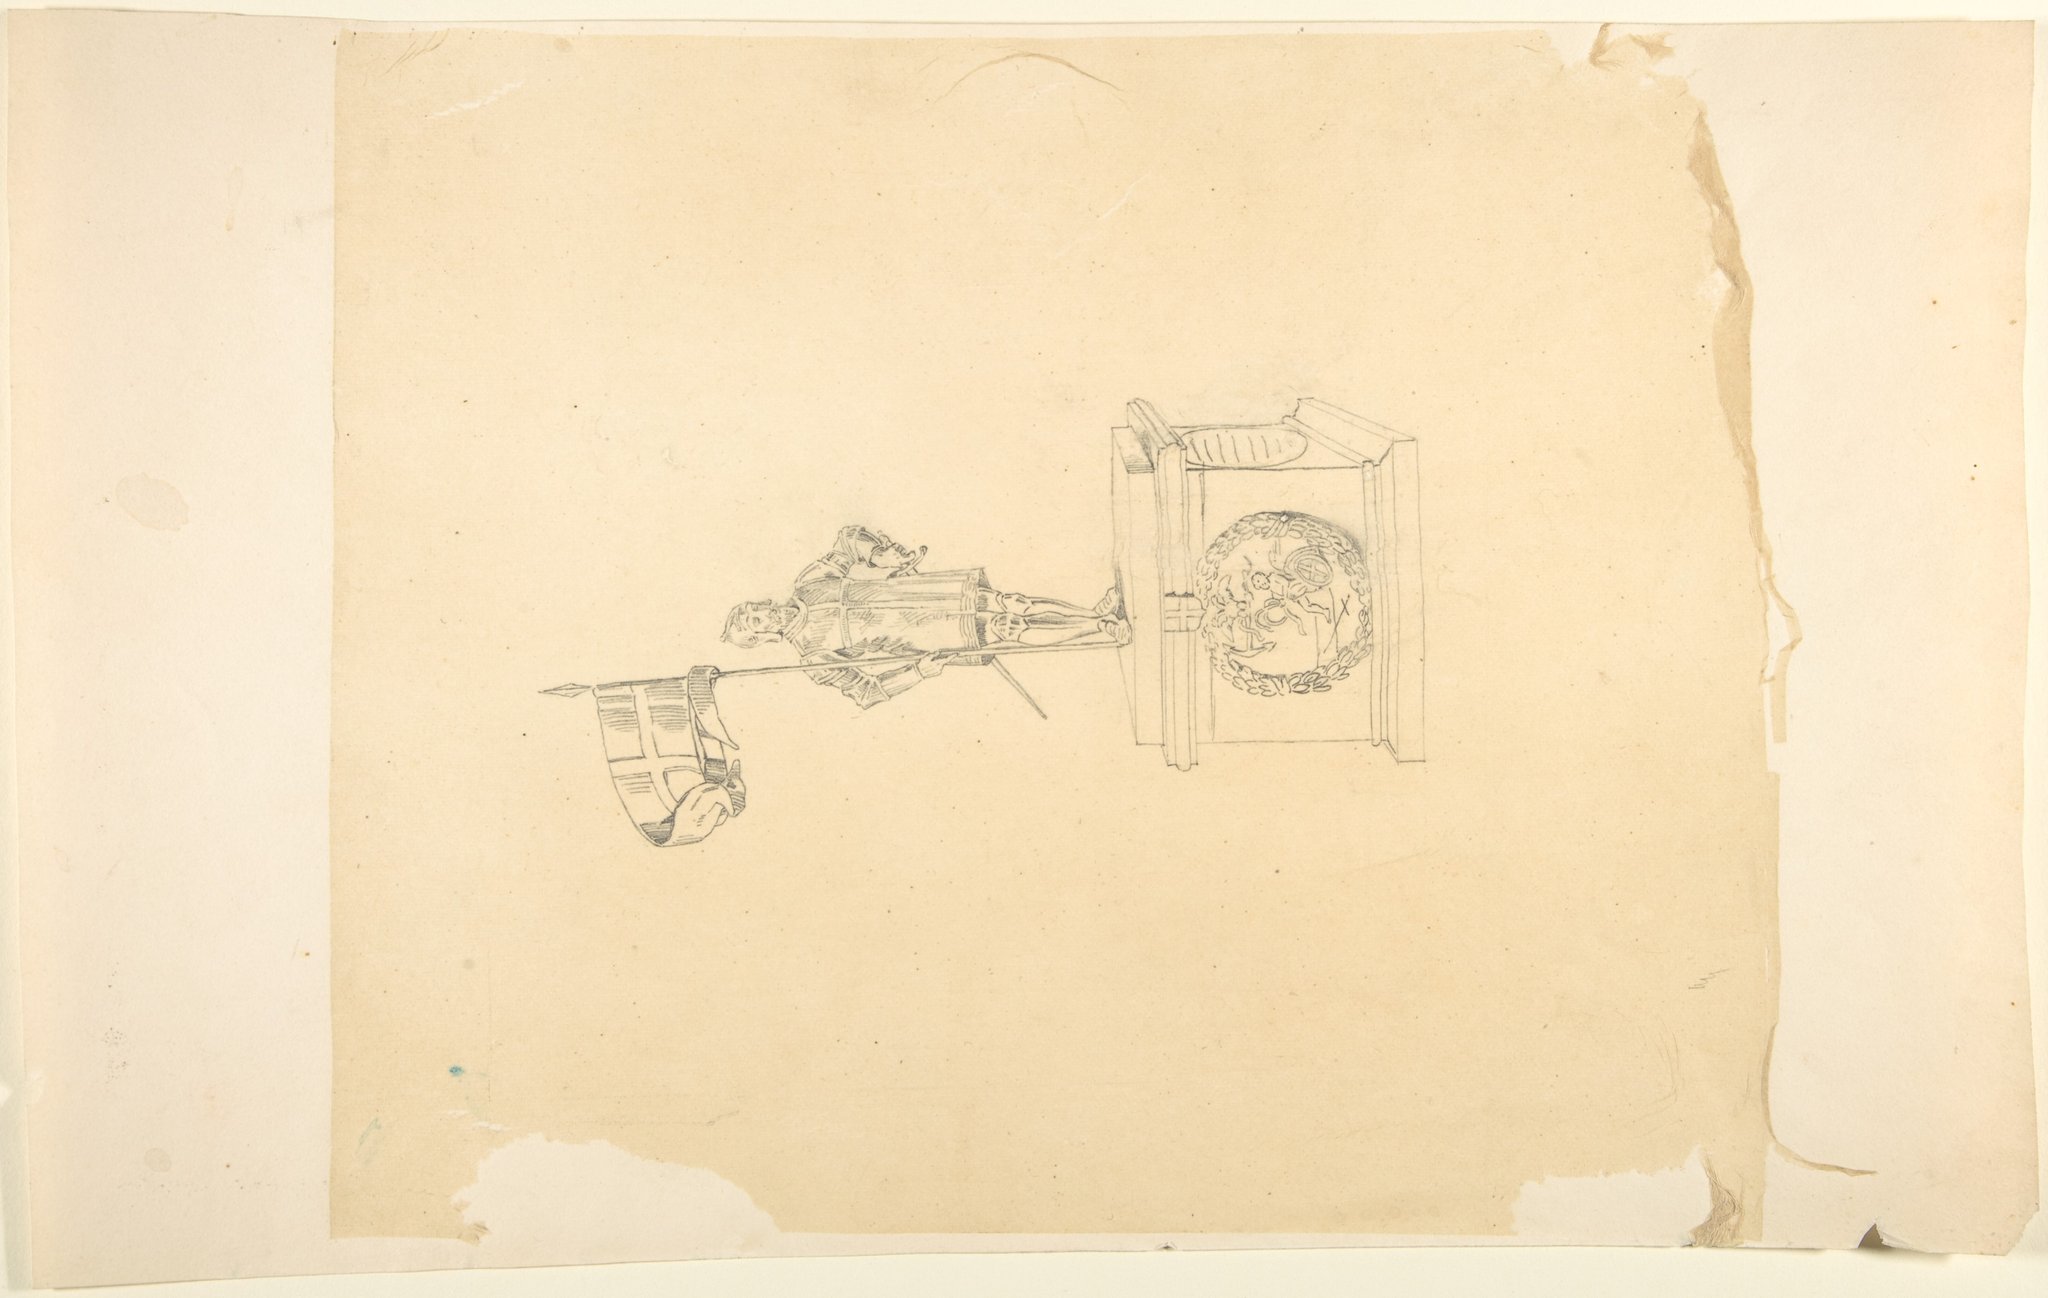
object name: drawing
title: Statue of a Knight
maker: franz von hauslab the younger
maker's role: artist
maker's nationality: austrian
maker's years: 1798-1883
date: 1801-1900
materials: pencil, paper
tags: men,flags,knights